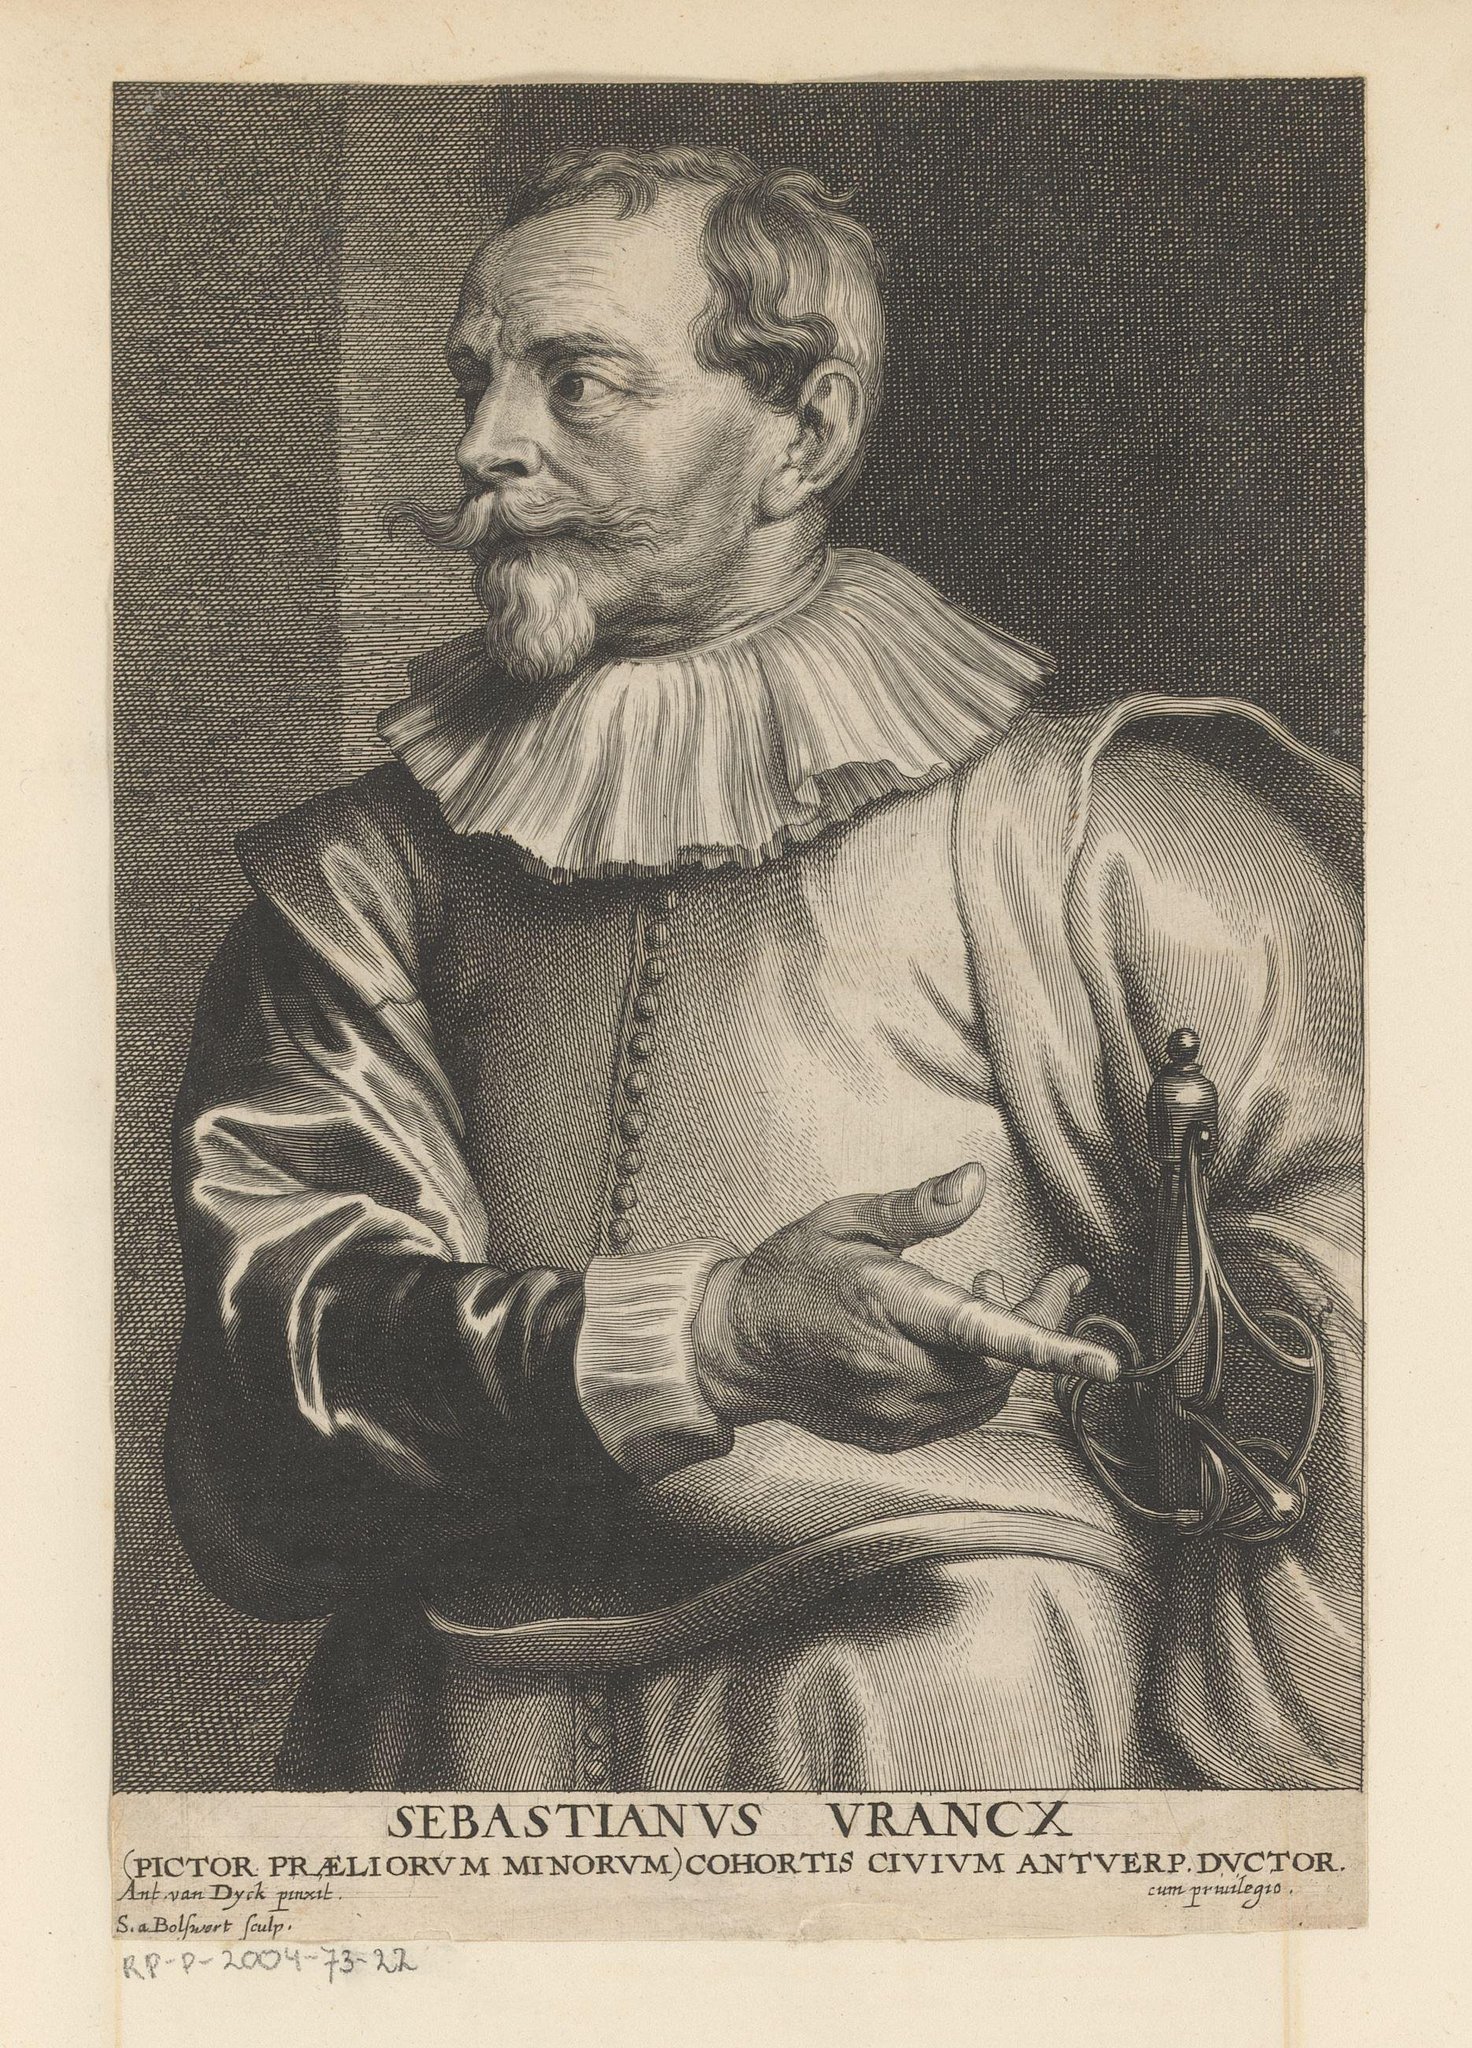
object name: book illustration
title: Portret van Sebastiaan Vrancx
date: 1759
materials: paper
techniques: engraving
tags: antwerp, painter, print maker, draughtsman, sebastiaen vrancx, historical persons, portrait, self-portrait of painter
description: Prent uit: Iconographie ou Vies des Hommes Illustres du XVII. Siecle (...). 2 dln. Amsterdam: Johann Caspar Arkstee, Leipzig: Henricus Merkus, 1759, dl. 2, p. 23. De samensteller heeft deze prent in het album geplakt als illustratie bij: Pilkington, Matthew en Johann Heinrich Füssli. A dictionary of painters, from the revival of the art to the present period. 4 dln. Londen: John Crowder, 1805, dl. 2, p. 197.